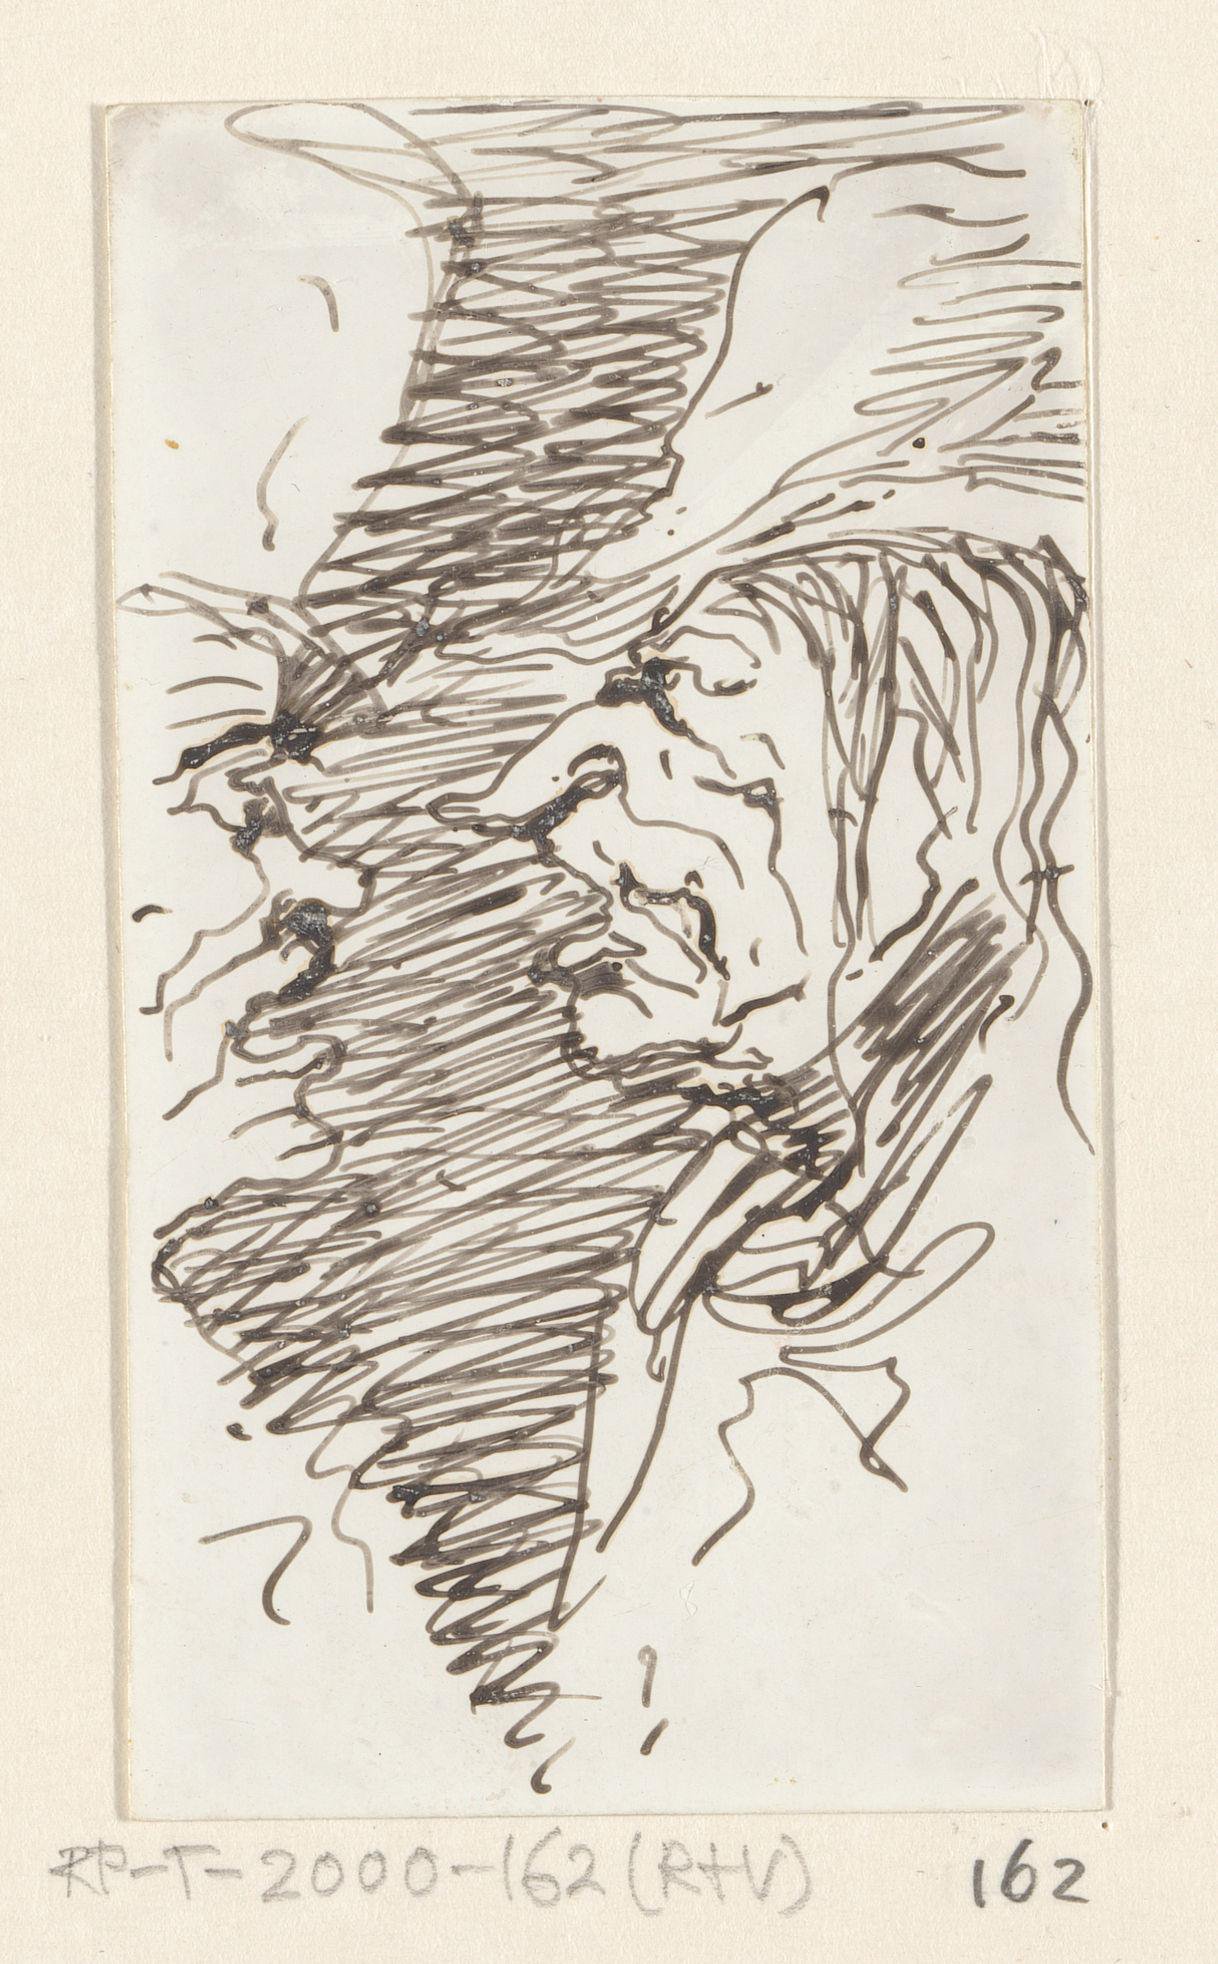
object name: drawing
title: Kop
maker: johannes tavenraat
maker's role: draughtsman, painter, print maker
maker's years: 1809-1881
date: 1870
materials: ink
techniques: pen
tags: caricatures (human types)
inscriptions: signature and date: ‘Tavenraat - 1/1 1870’, collector's mark: Lugt 2228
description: Karikaturale kop met hoge hoed, getekend op de keerzijde van het visitekaartje van: 'M.W. van Pesch, Swijndregt'.